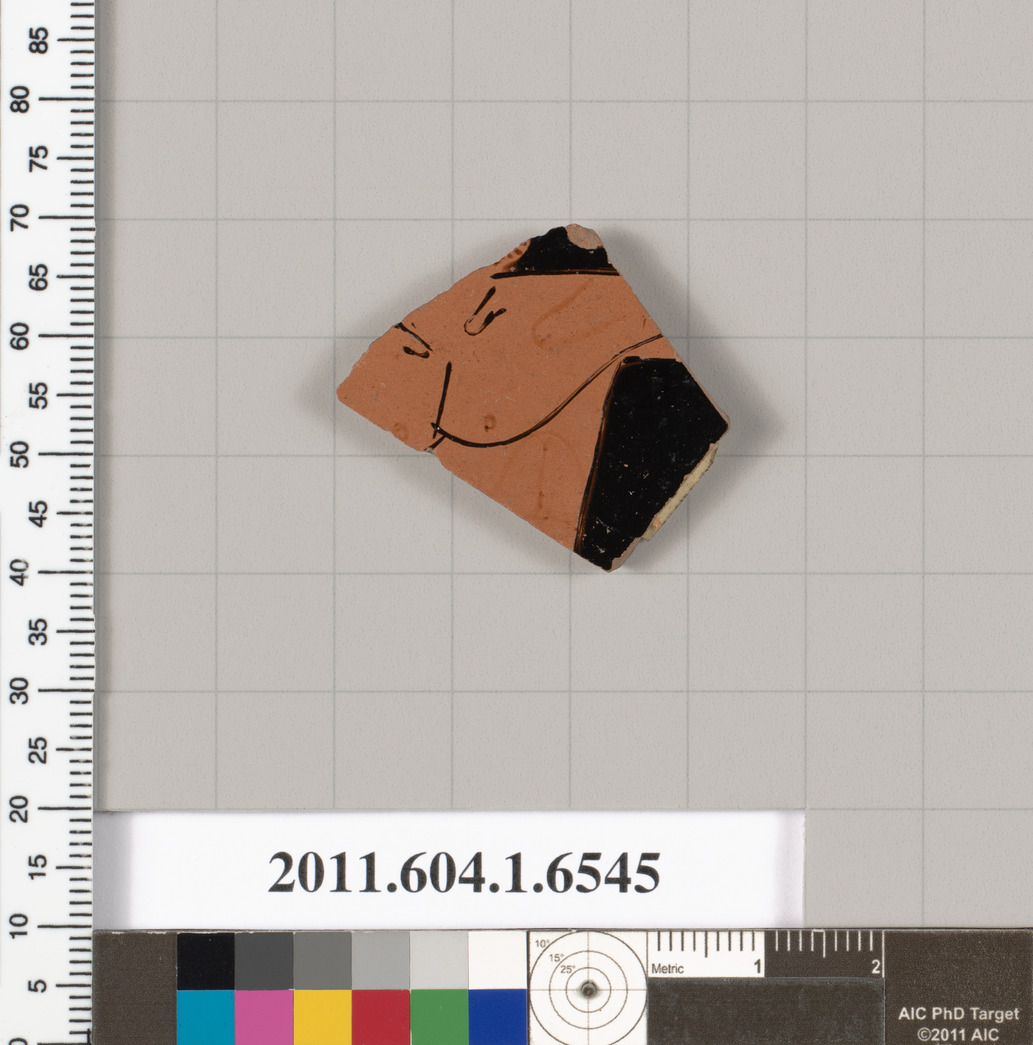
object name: kylix fragment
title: Terracotta fragment of a kylix (drinking cup)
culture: greek, attic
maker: colmar painter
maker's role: artist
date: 490-480 BCE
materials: terracotta